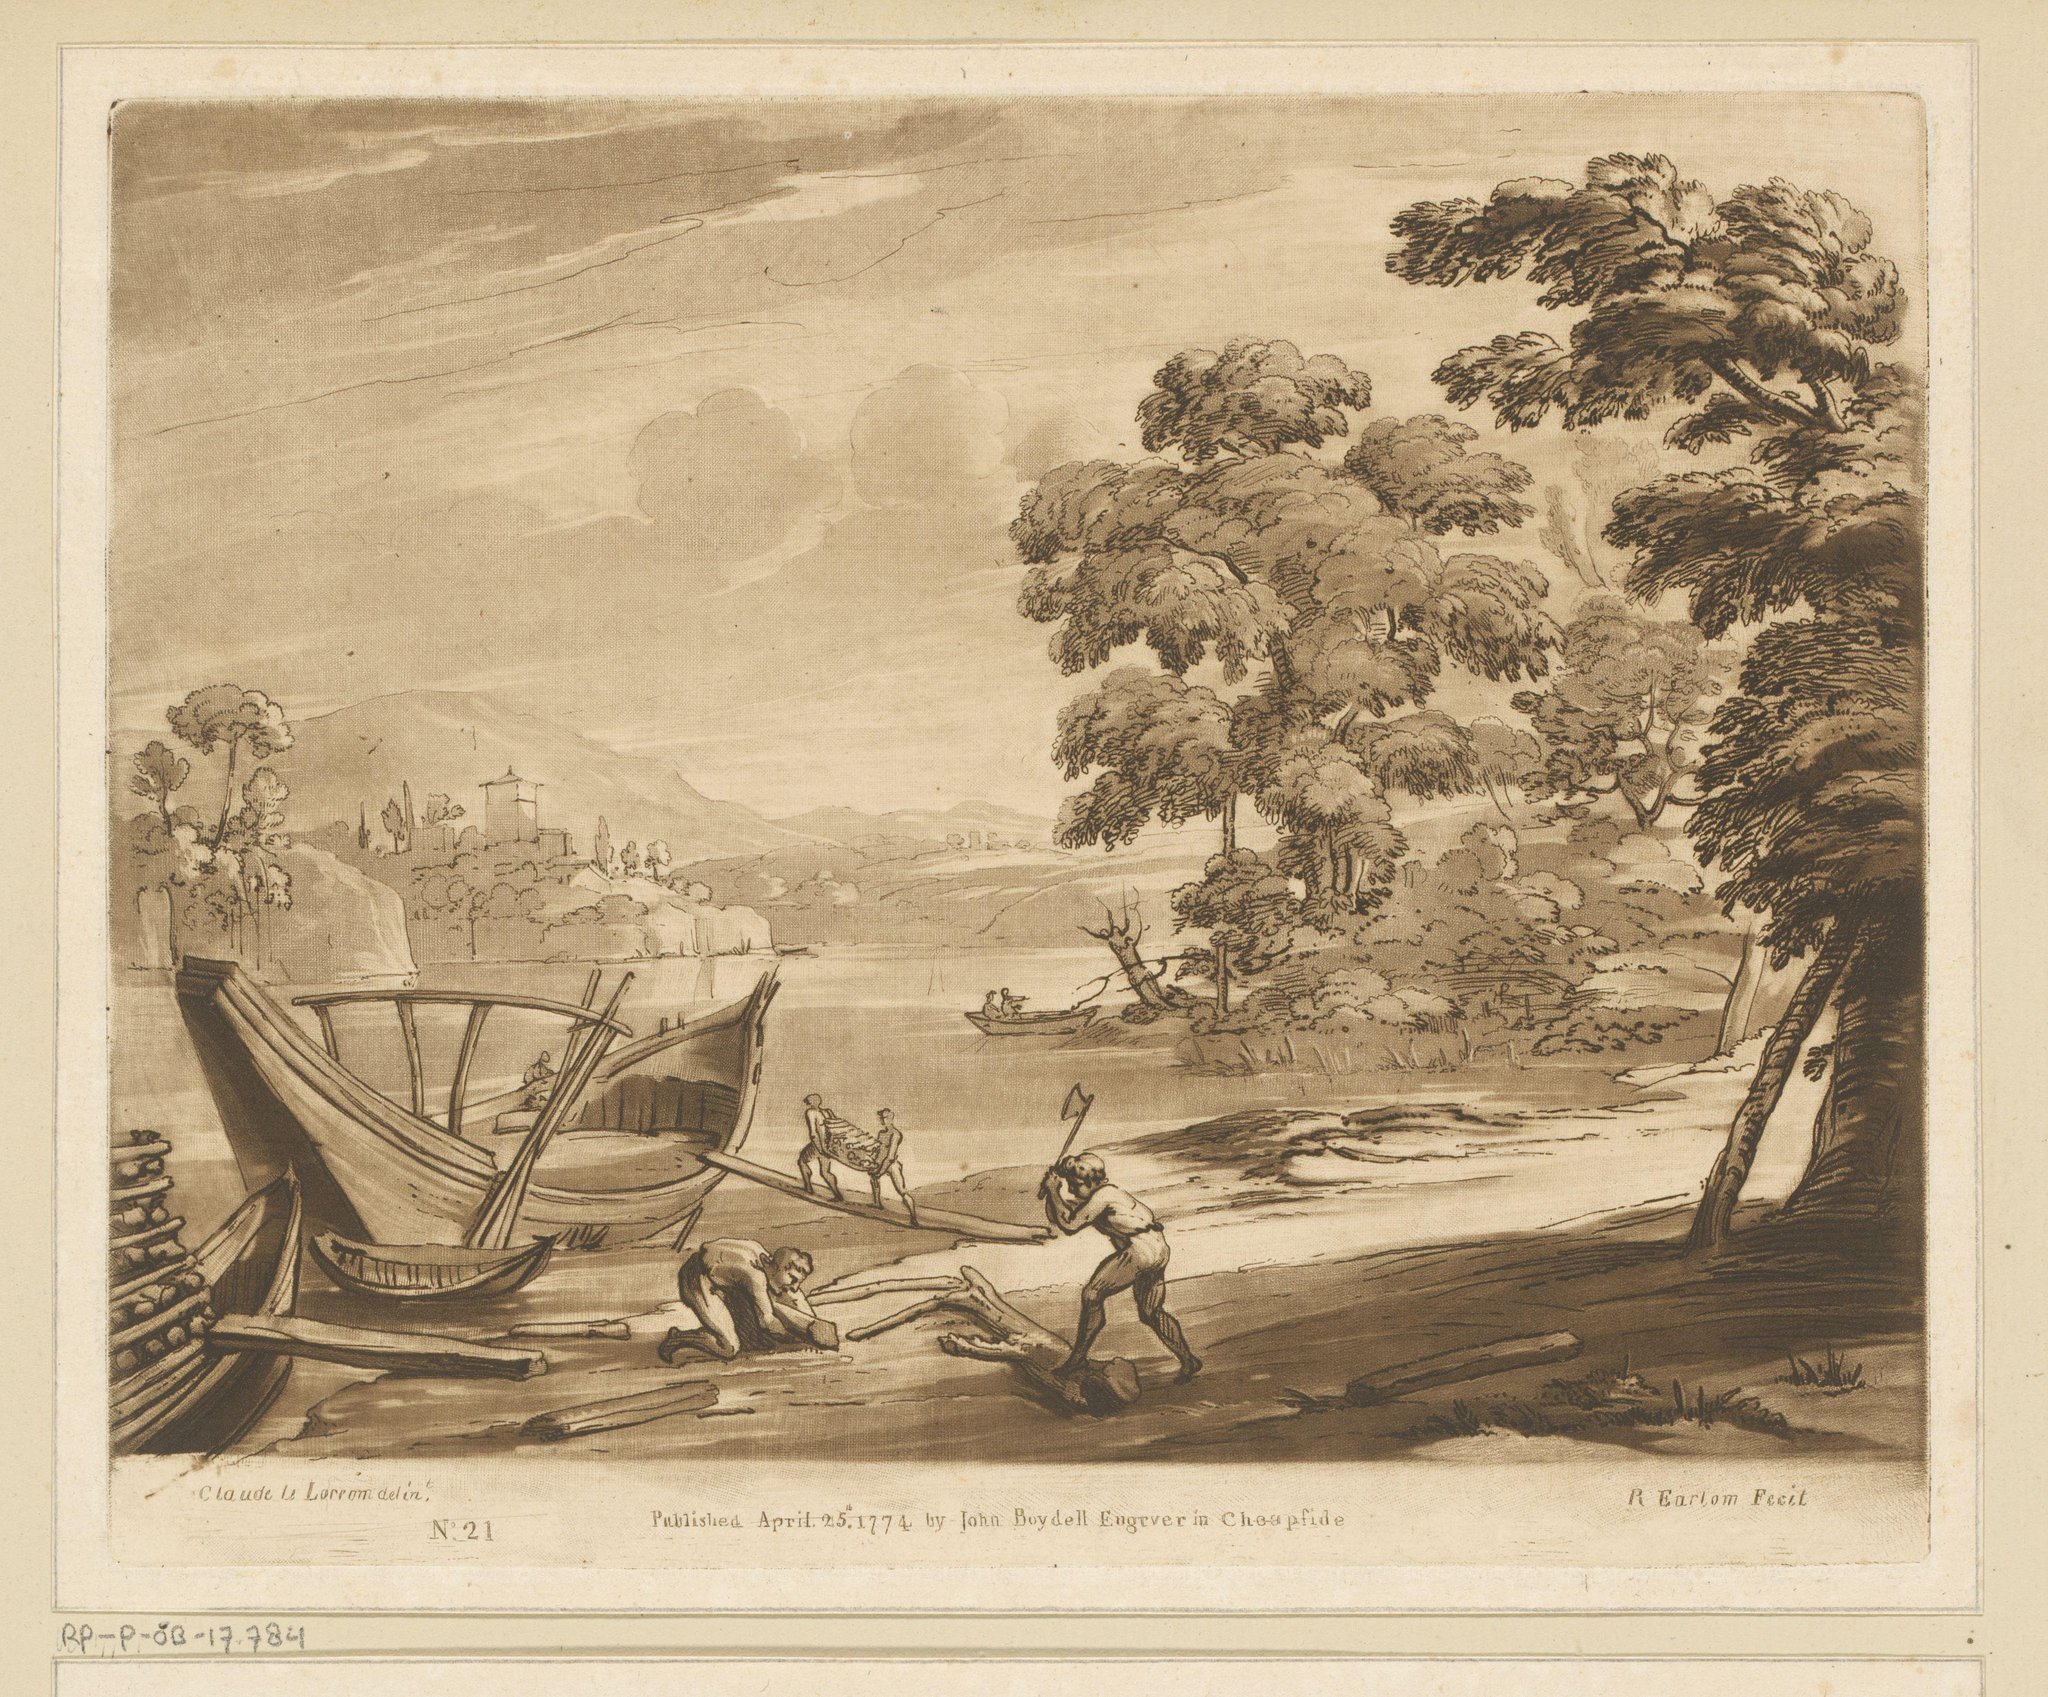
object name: print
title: Landschap met meer en mannen bezig met scheepsbouw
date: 1774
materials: paper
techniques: etching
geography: london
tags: building a ship, ship under construction, lake, shipyard-workers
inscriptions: date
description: Vanaf 1774 publiceerde John Boydell tweehonderd prenten naar het tekeningenboek Liber Veritatis van Claude Lorrain, in het bezit van de hertogen van Cavendish. Deze prenten werden vanaf 1777 in twee volumes gebundeld uitgegeven.